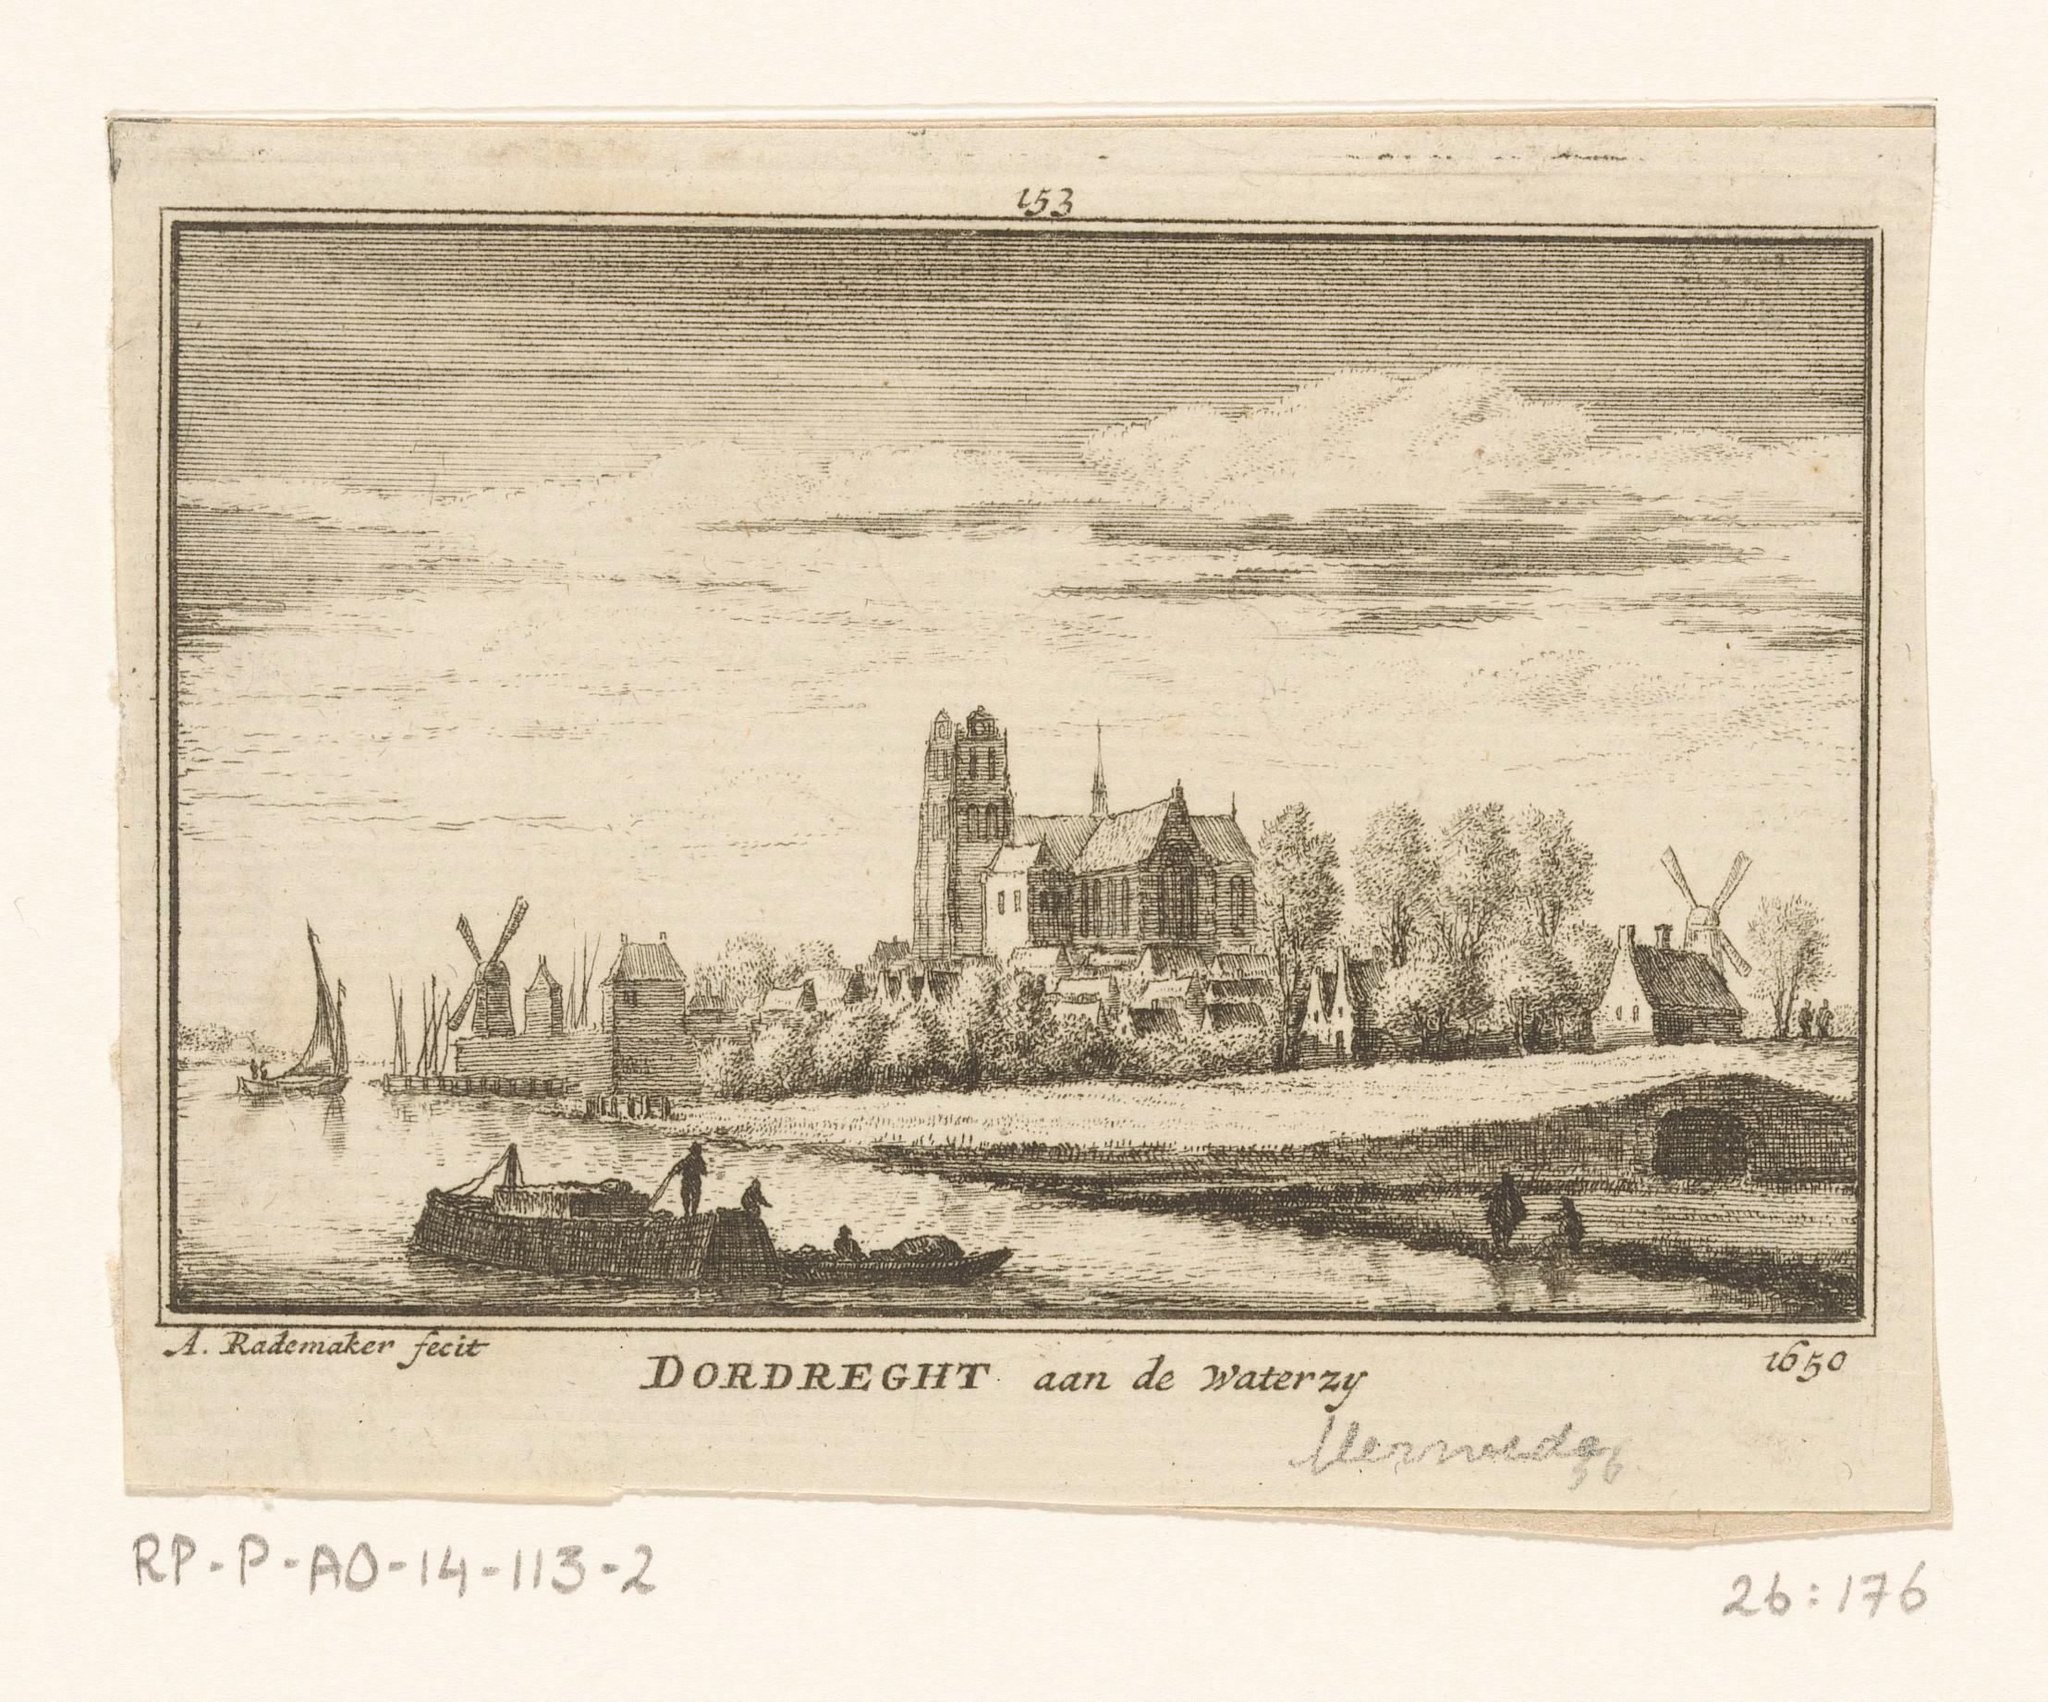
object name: print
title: Dordreght aan de waterzy 1650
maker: abraham rademaker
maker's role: draughtsman, print maker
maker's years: 1676-1735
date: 1725-1803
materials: paper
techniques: engraving, etching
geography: amsterdam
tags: machine driven by wind, sailing-ship, sailing-boat, church (exterior), rowing-boat, canoe, etc., prospect of city, town panorama, silhouette of city, dordrecht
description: Prent ook gebruikt in: Rademaker, Abraham. Kabinet van Nederlandsche outheden en gezichten: vervat in 300 konstplaaten (…). 2 delen. Amsterdam: Willem Barents, 1725, dl. 2, ill. 153. Na 1725 is deze prent nog in verschillende heruitgaven verschenen, uitgegeven in 1727-1733, 1770-1771 en 1792-1803. Uit welke uitgave het huidige exemplaar precies komt is niet na te gaan.